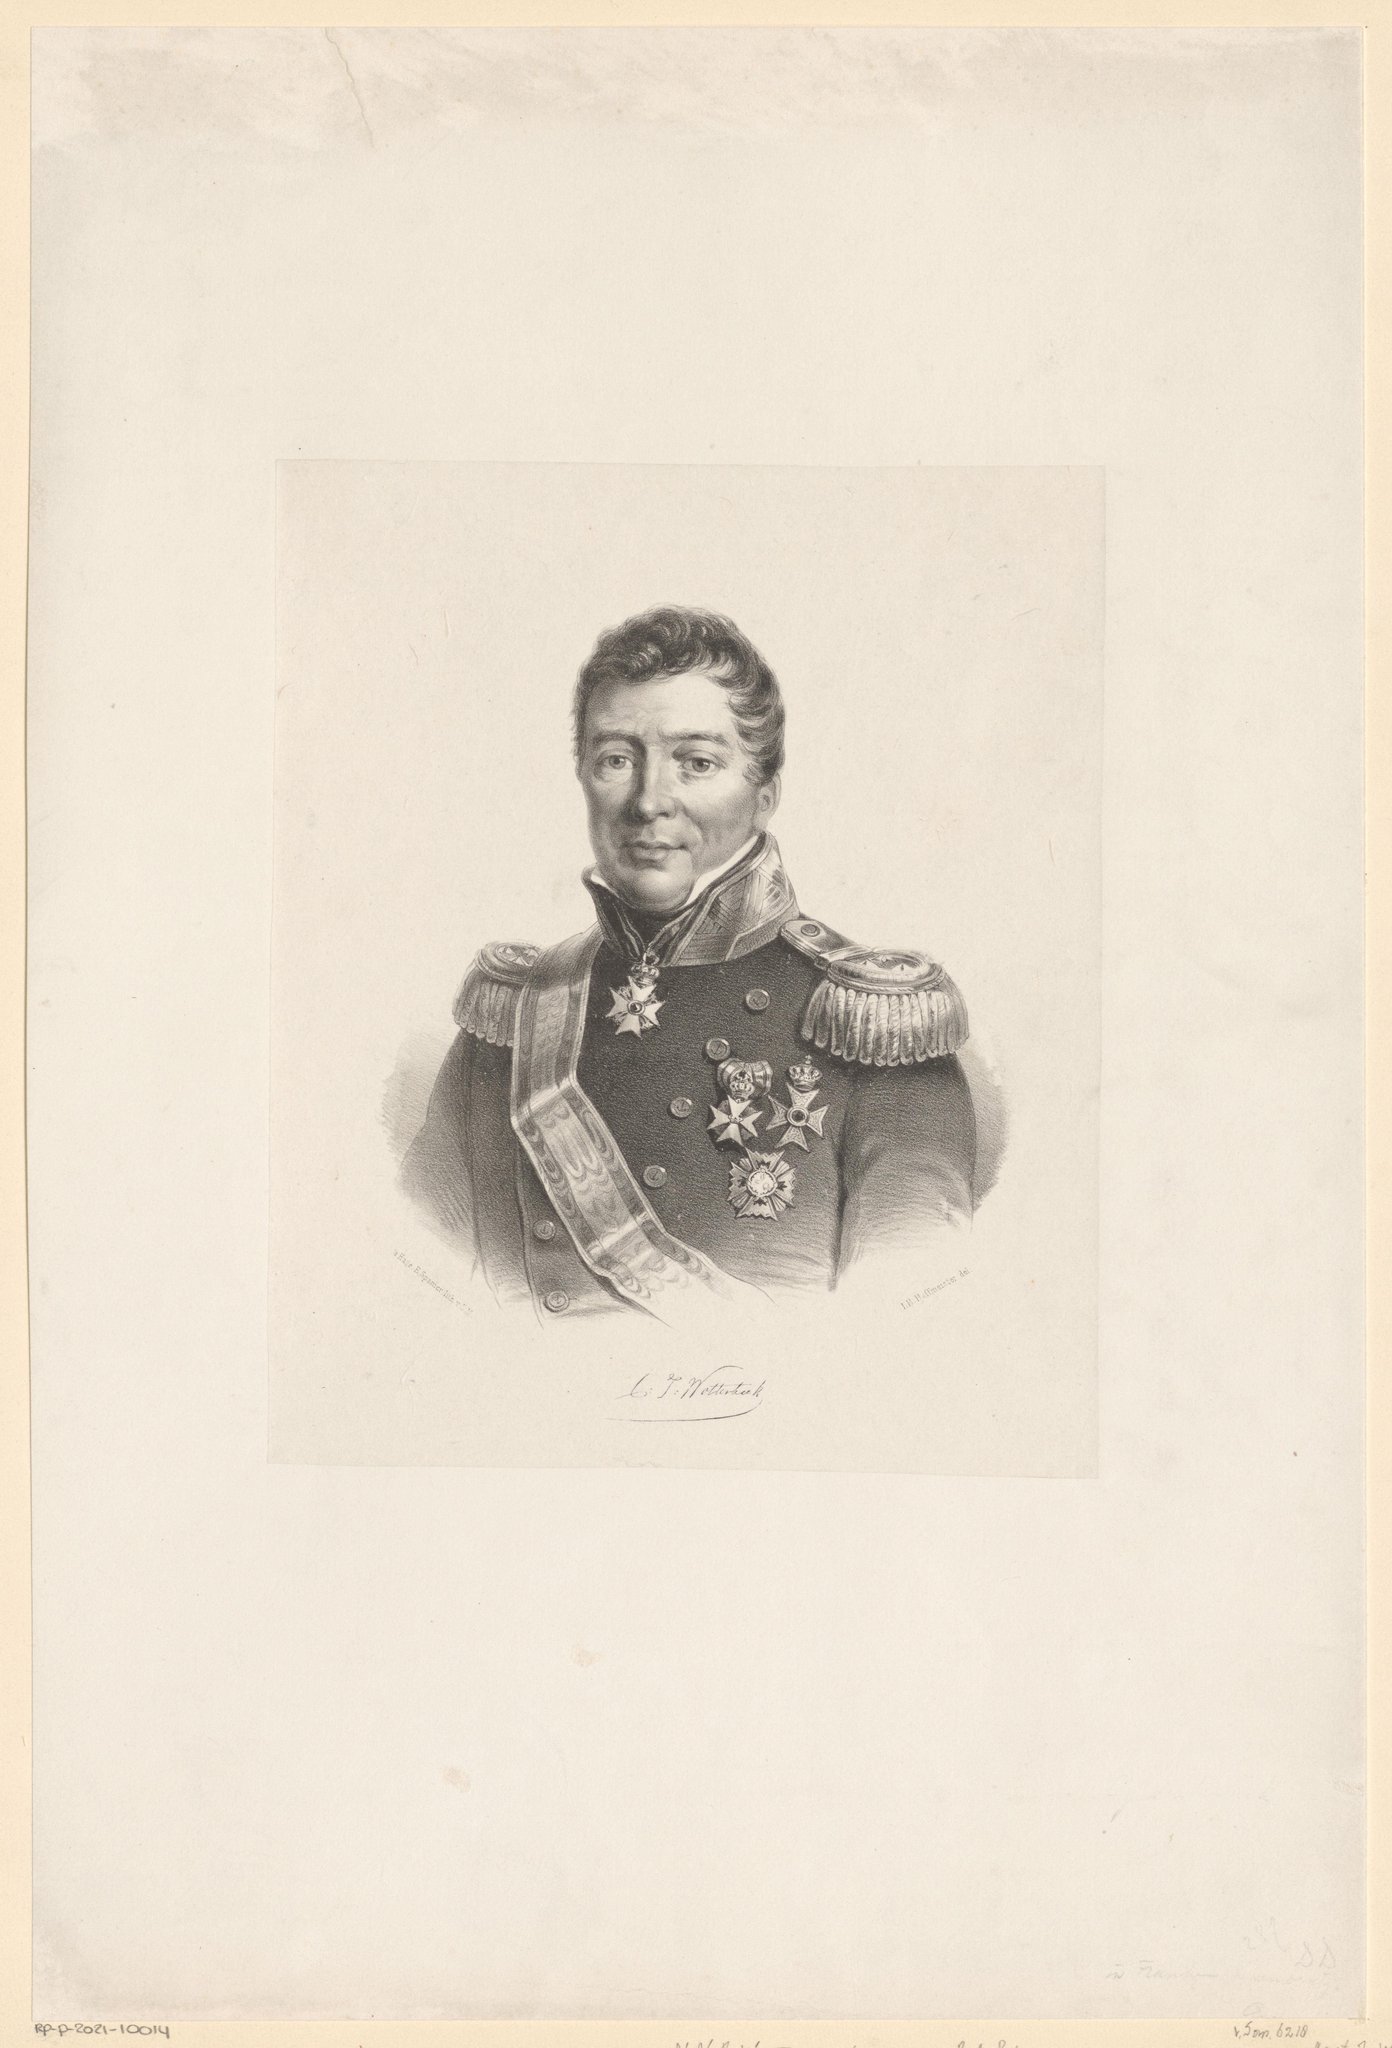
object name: print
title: Portret van Constantijn Johan Wolterbeek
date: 1843-1863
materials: paper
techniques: lithograph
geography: netherlands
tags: the hague, knighthood order, historical persons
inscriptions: collector's mark: Lugt 2228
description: Onder het portret een facsimile van de handtekening van de geportretteerde.